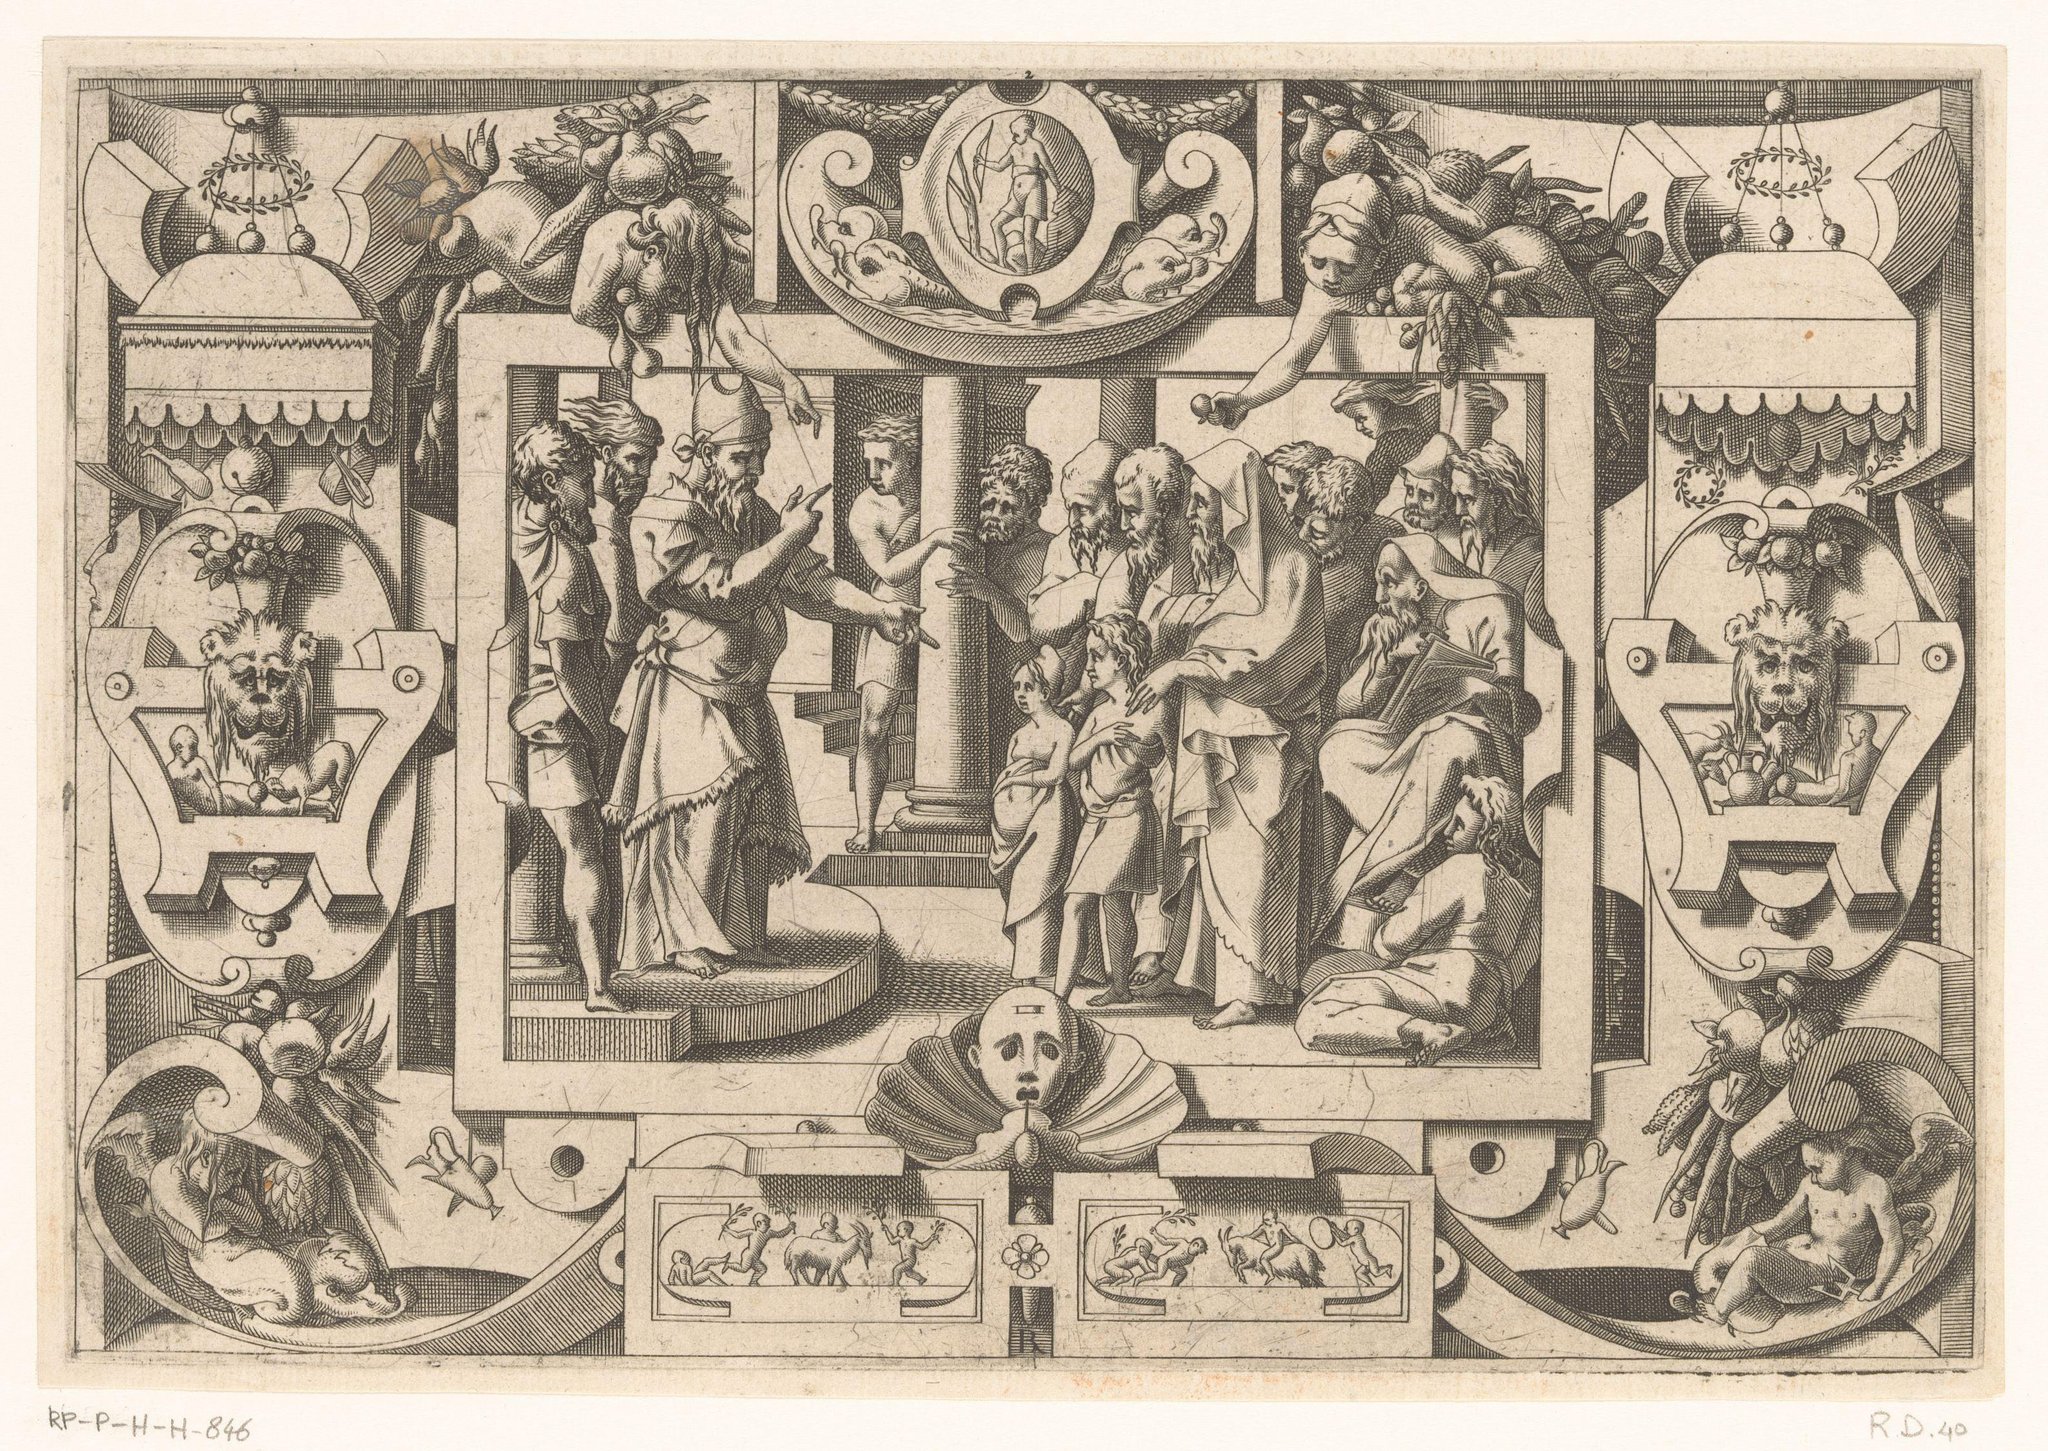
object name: print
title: Histoire de Jason et de la conquête de la toison d'or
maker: rené boyvin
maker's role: print maker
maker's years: 1525-1598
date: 1563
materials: paper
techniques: engraving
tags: ino's machination against phrixus and helle, nephele's children, athamas with his children by nephele, phrixus and helle, before the priest, the story of the argonauts: the quest for the golden fleece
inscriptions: collector's mark: Lugt 11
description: Maakt deel uit van een serie van 26 prenten met scènes uit het verhaal van Jason en het gulden vlies, uitgegeven in 1563 te Parijs.